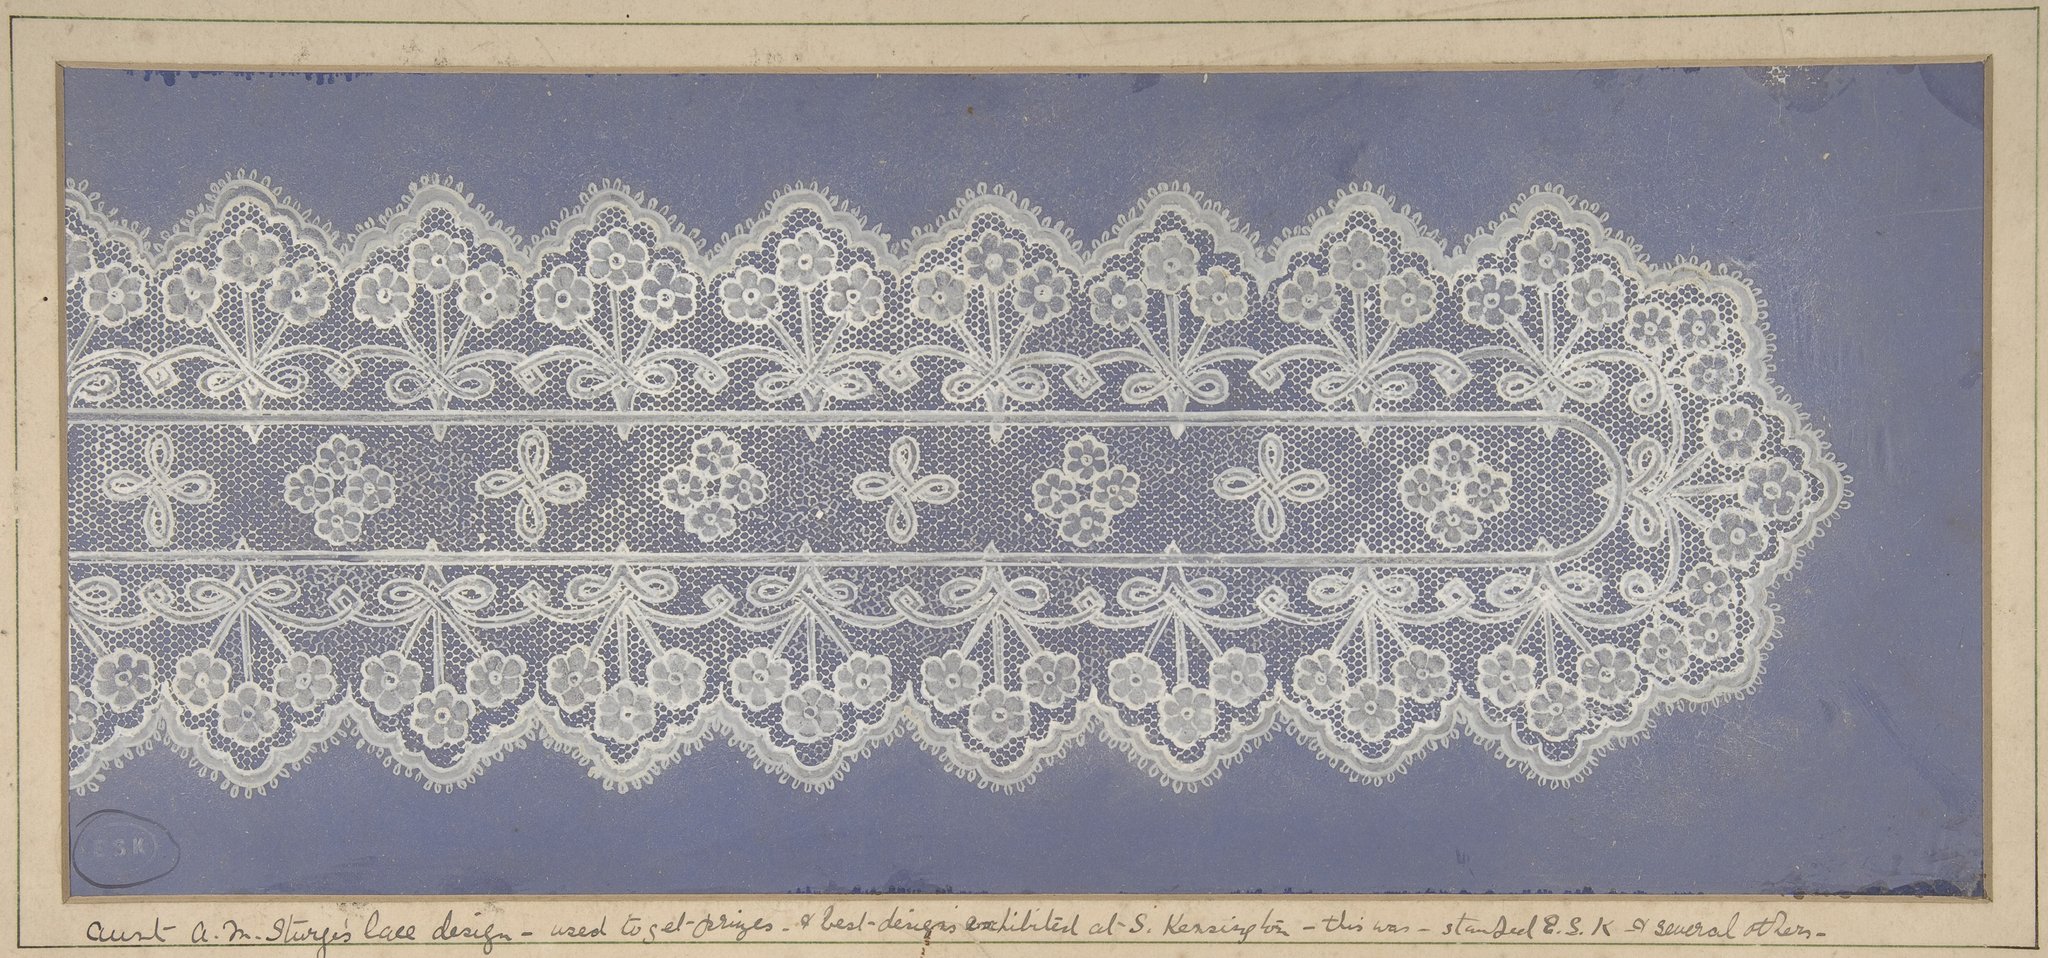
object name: drawing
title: Design for lace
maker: anonymous, british, 19th century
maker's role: artist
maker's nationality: british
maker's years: 1800-1900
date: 1801-1900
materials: gouache